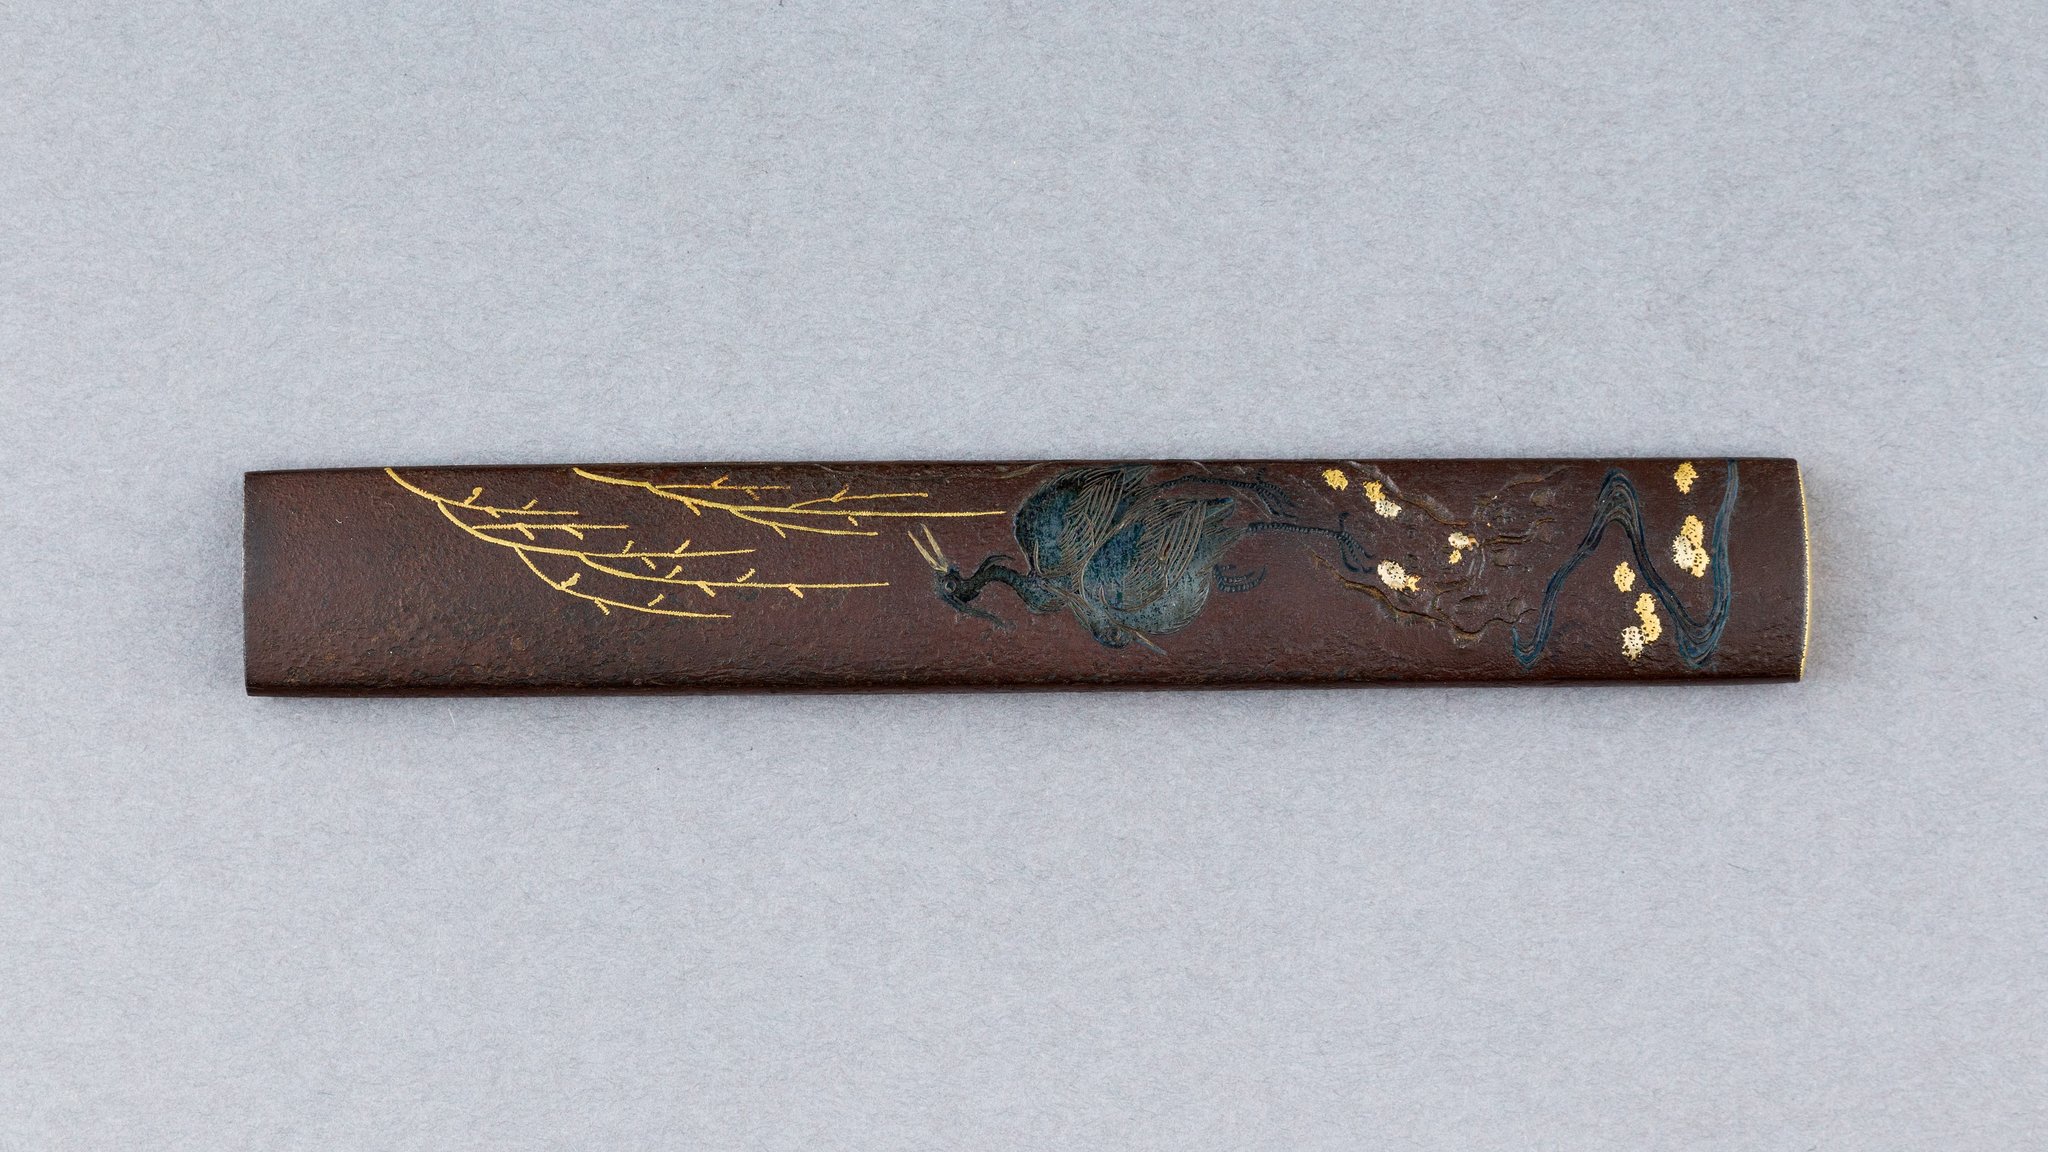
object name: knife handle kozuka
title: Knife Handle (Kozuka)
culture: japanese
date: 1615-1868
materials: silver alloy, gold, iron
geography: japan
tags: birds